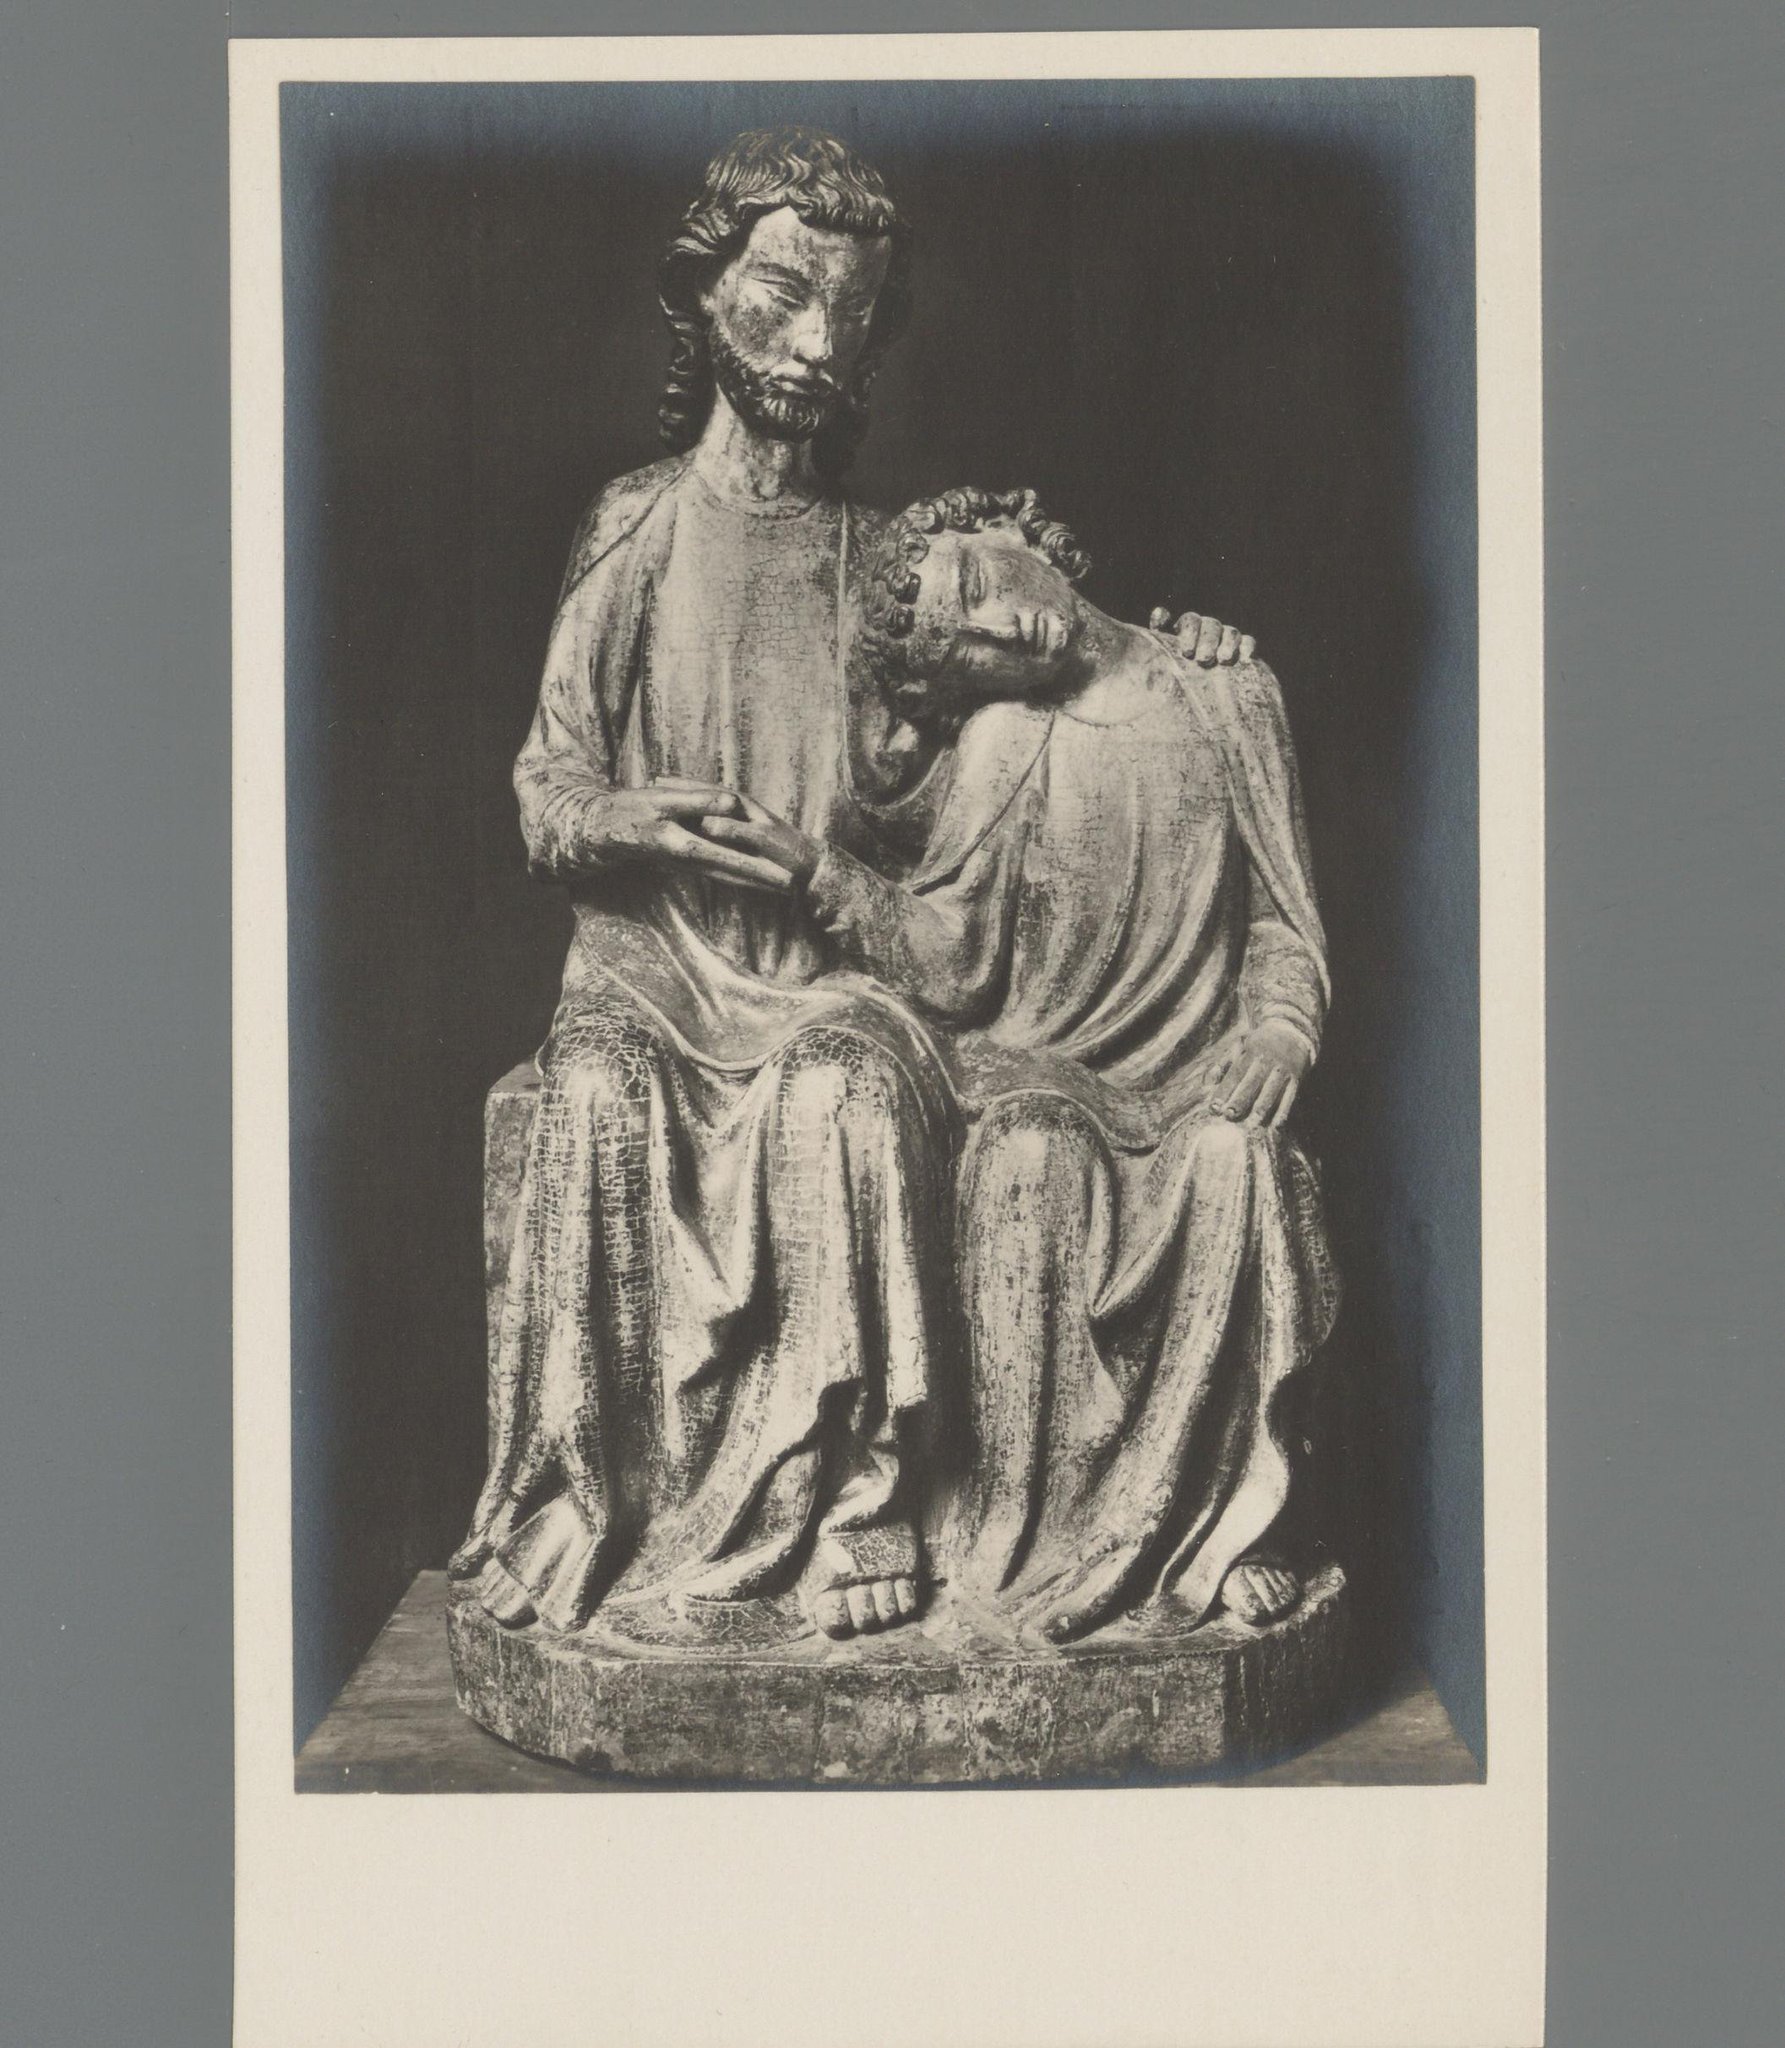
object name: photograph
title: Kaiser-Friedrich-Museum Berlin. Jesus u. Johannes aus Sigmaringen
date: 1904-1930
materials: photographic support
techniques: photography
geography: berlin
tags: statues, paintings, etc. ~ objects of worship in roman religion, permanent exhibition, museum